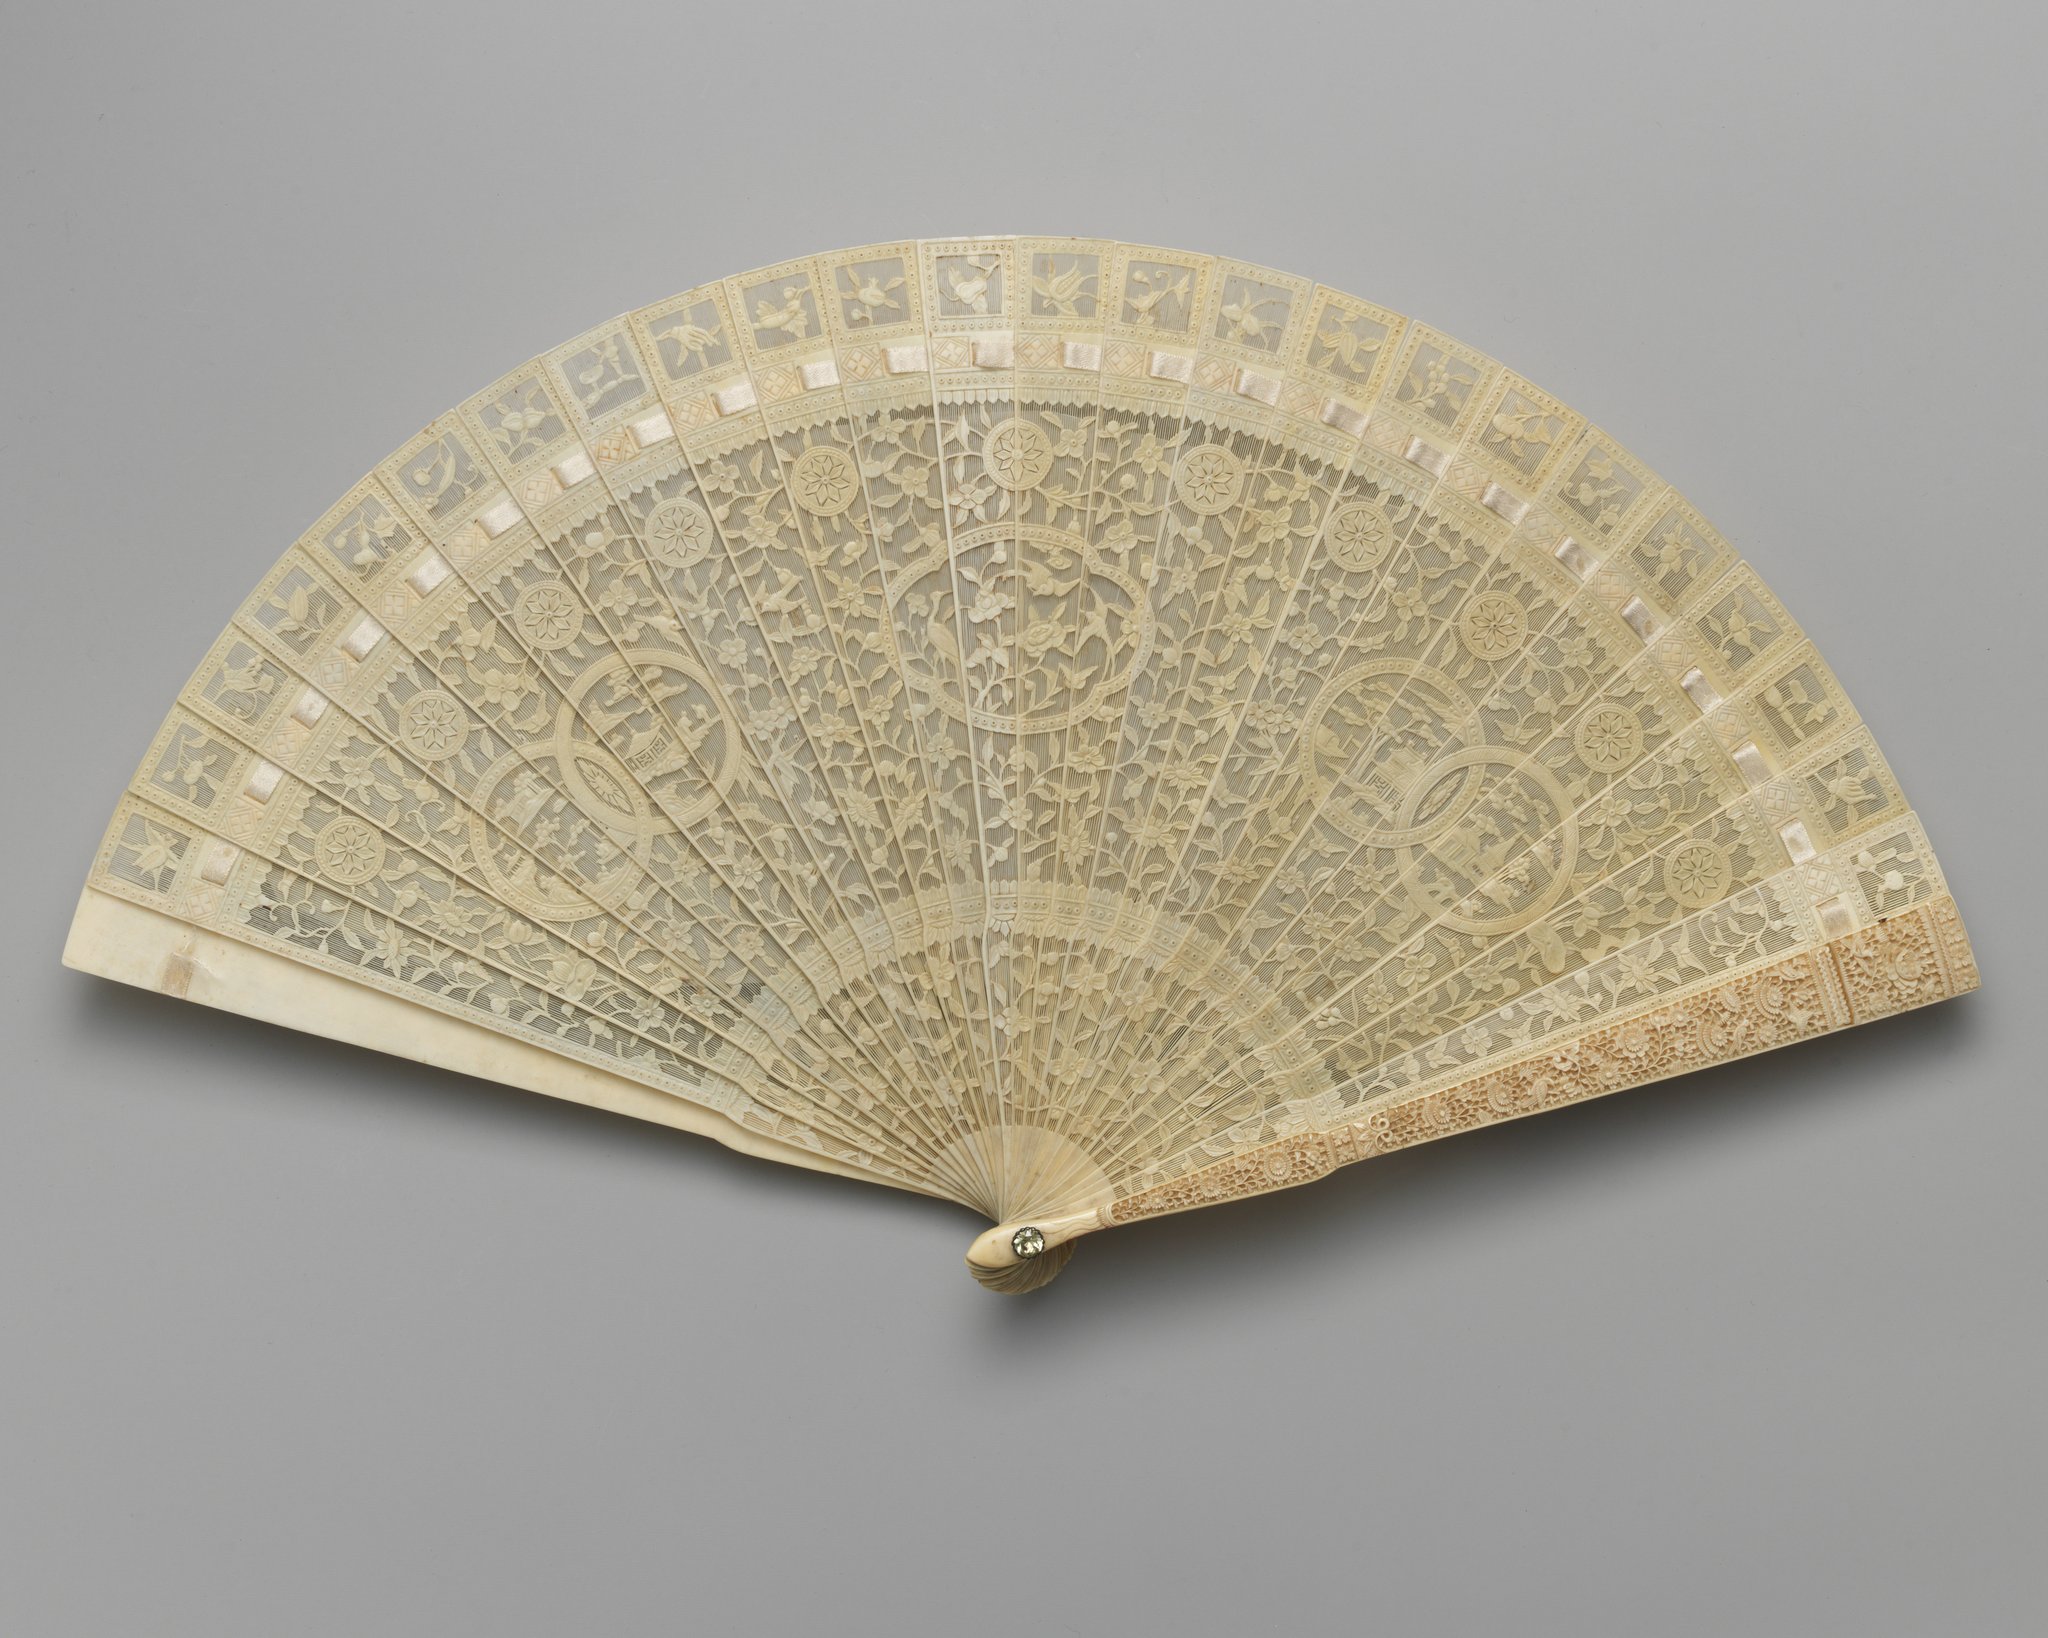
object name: fan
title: Brisé Fan, with Representations of Pavilions and Cranes, Surrounded by Flowers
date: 1767-1800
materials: ivory